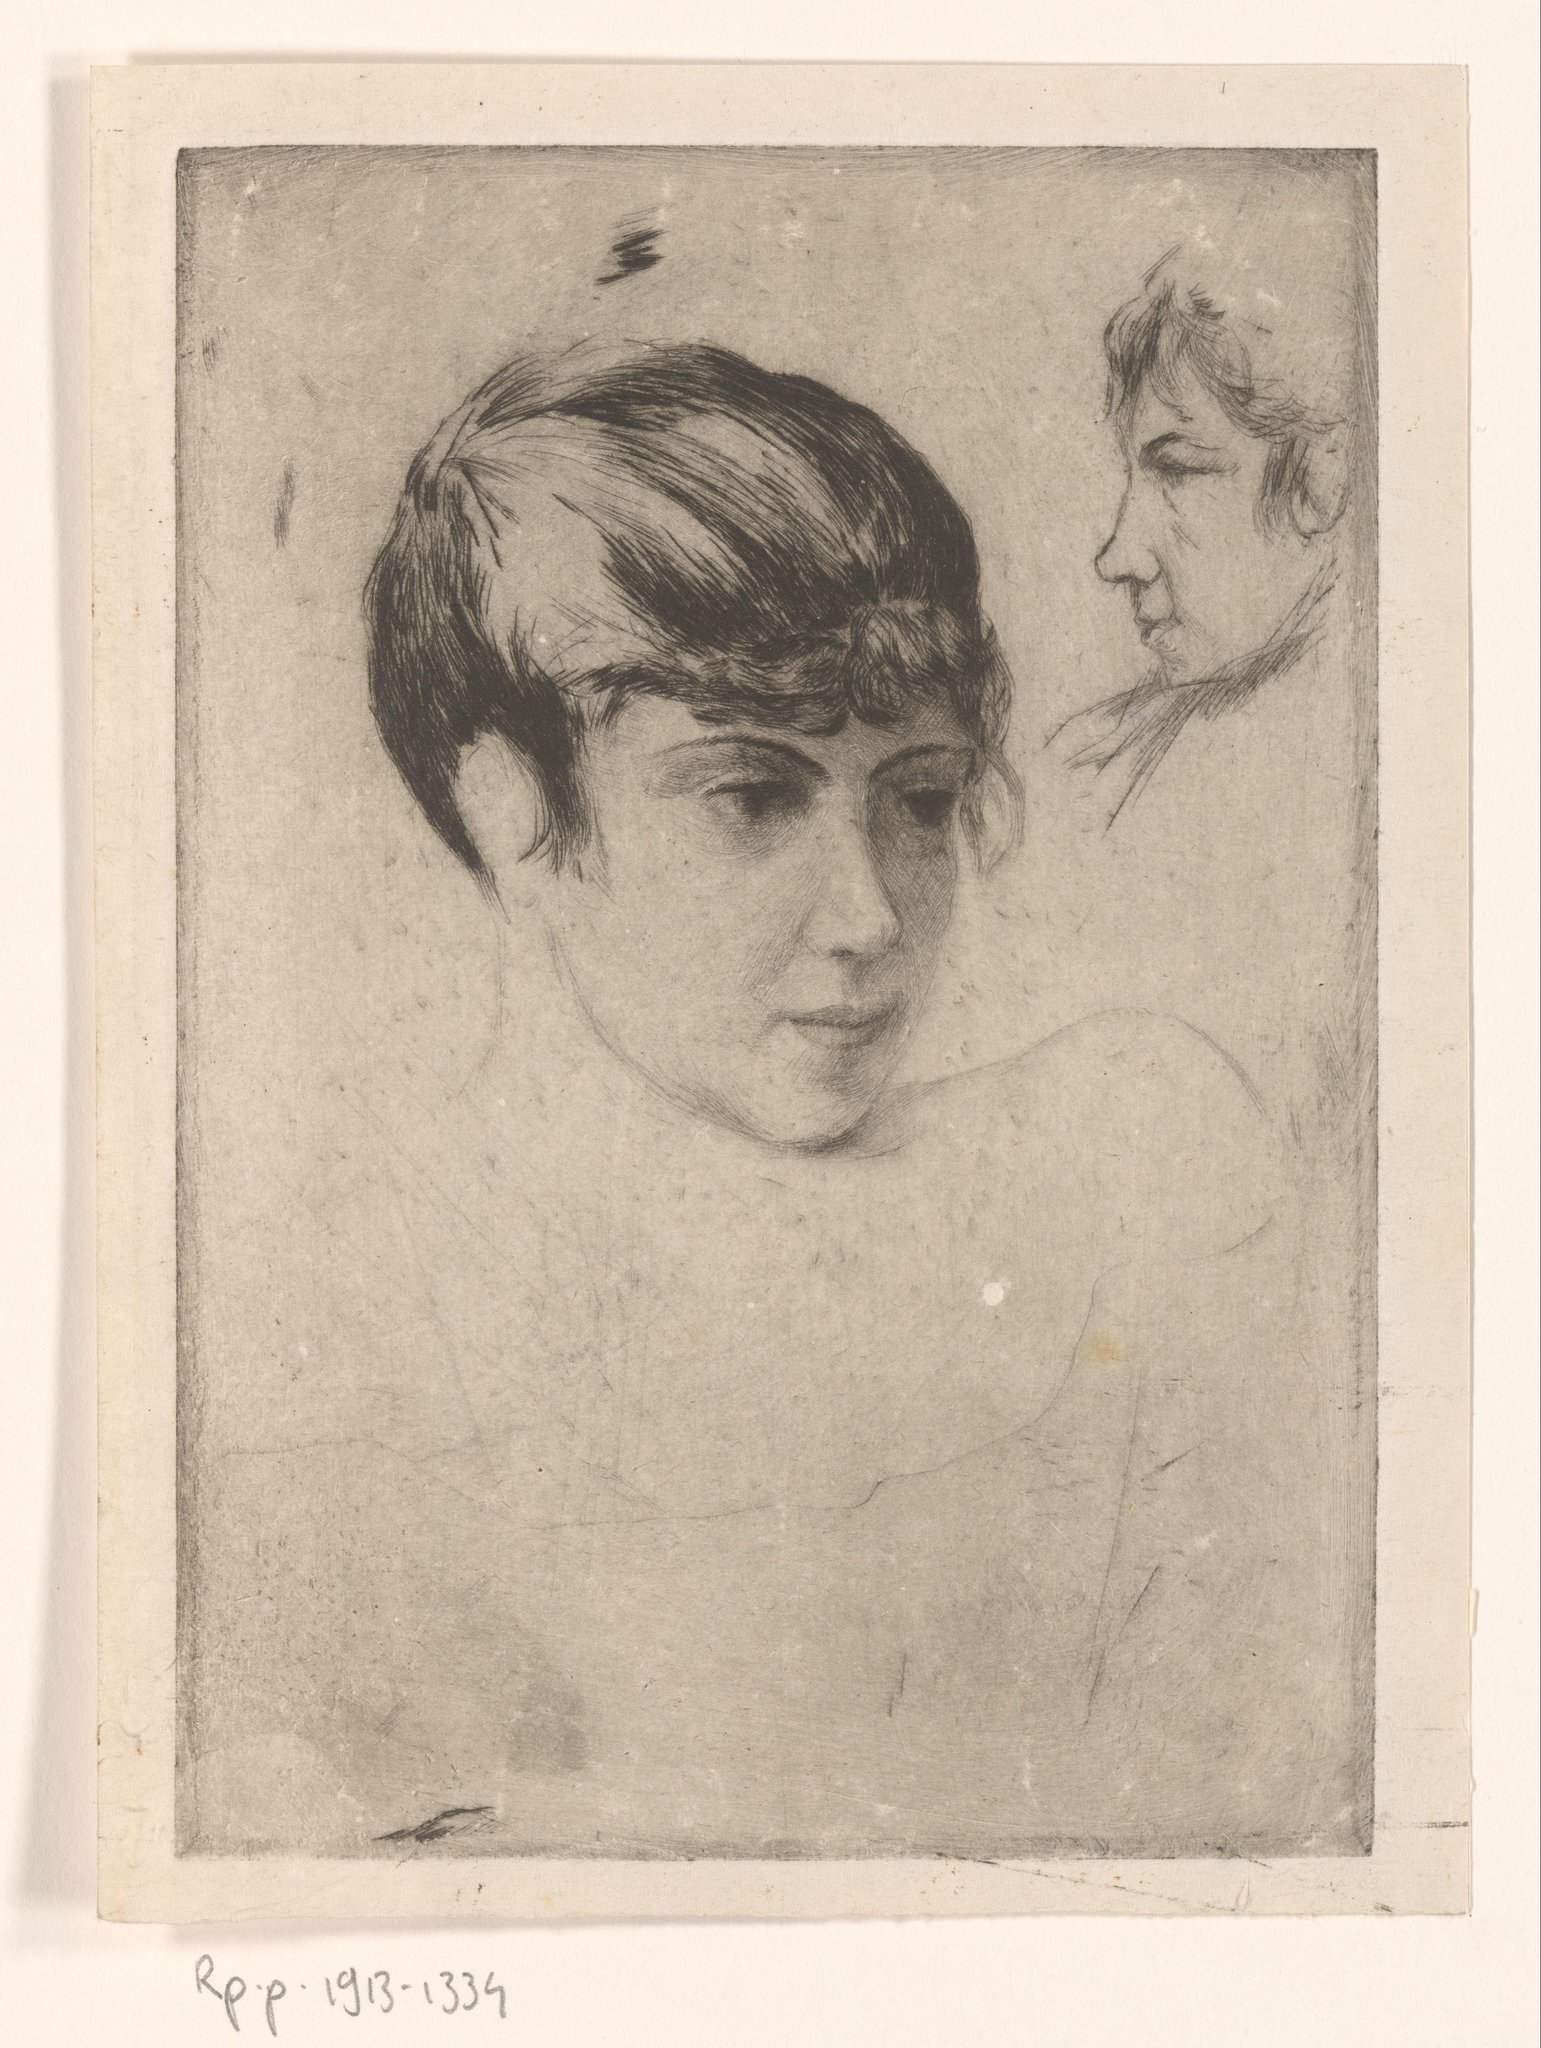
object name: print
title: Hoofd van een meisje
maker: philip zilcken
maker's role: draughtsman, painter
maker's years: 1857-1930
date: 1867-1890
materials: paper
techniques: drypoint, intaglio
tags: adolescent, young woman, maiden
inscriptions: collector's mark: Lugt 2233